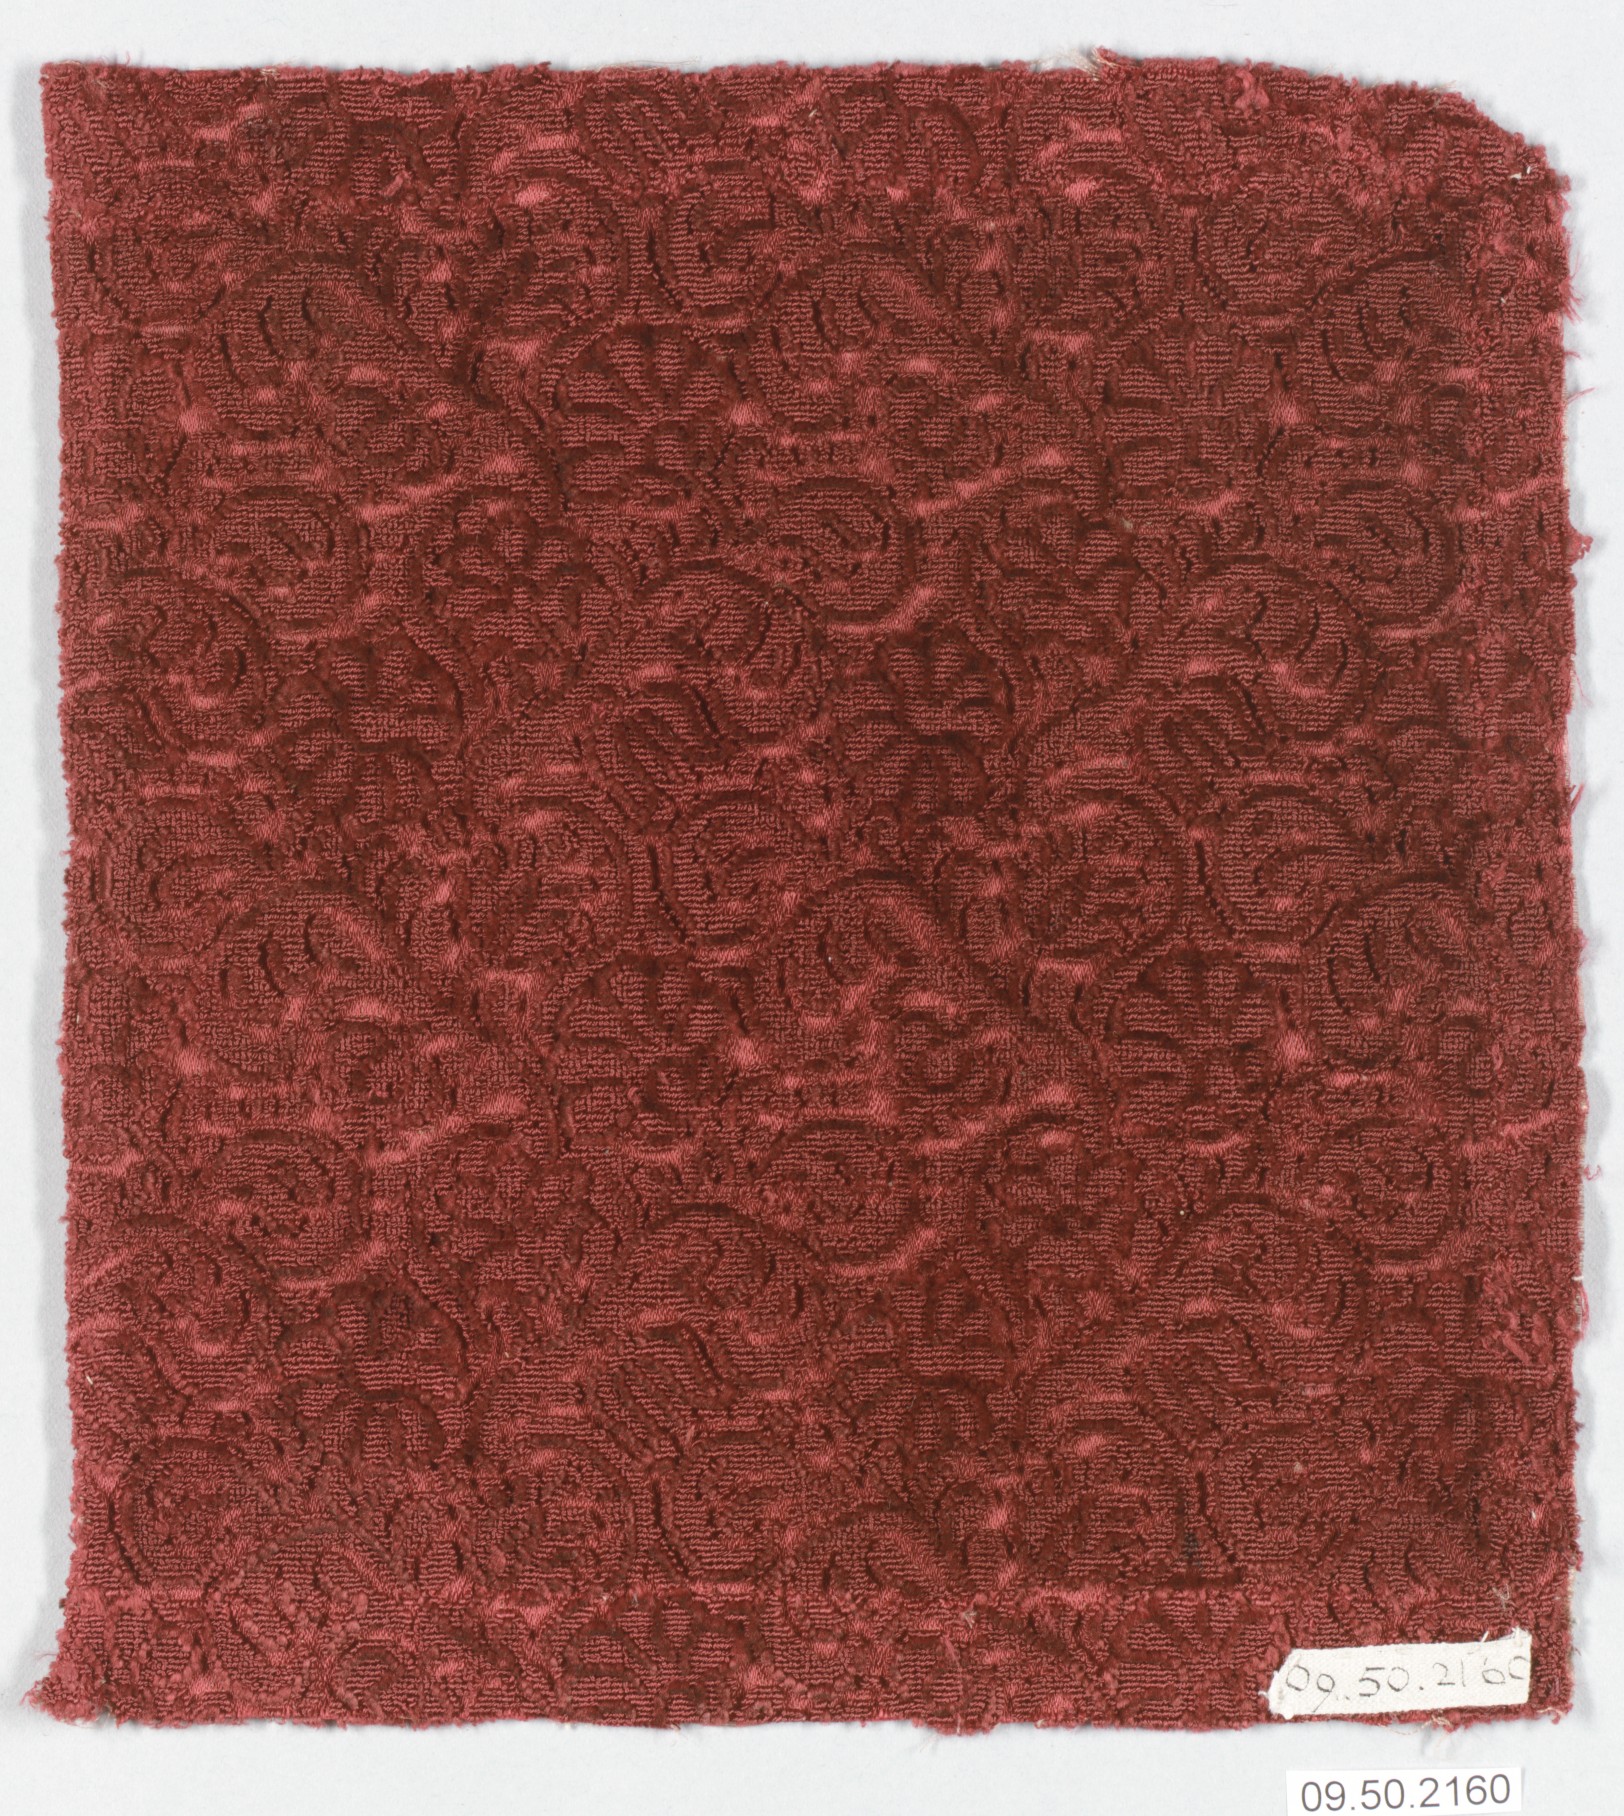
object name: piece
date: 1501-1700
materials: silk